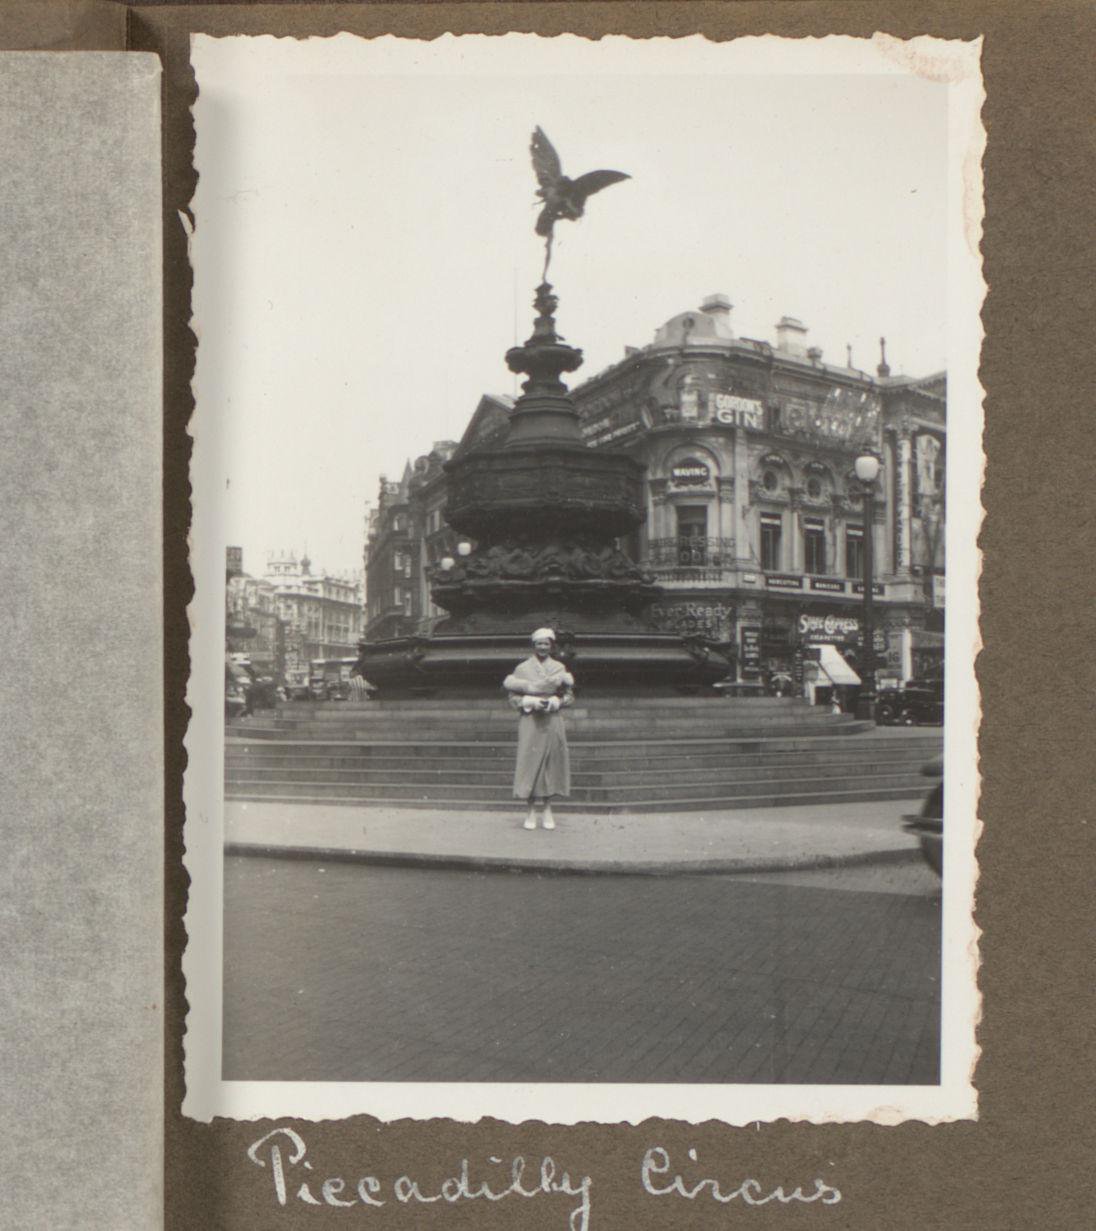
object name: album leaf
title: Wilhelmina van Zijll de Jong op Piccadilly Circus, Londen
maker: Anonymous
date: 1906-1933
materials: paper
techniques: gelatin silver print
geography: london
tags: wilhelmina van zijll de jong, monument, statue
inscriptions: inscription: ‘Piccadilly Circus’